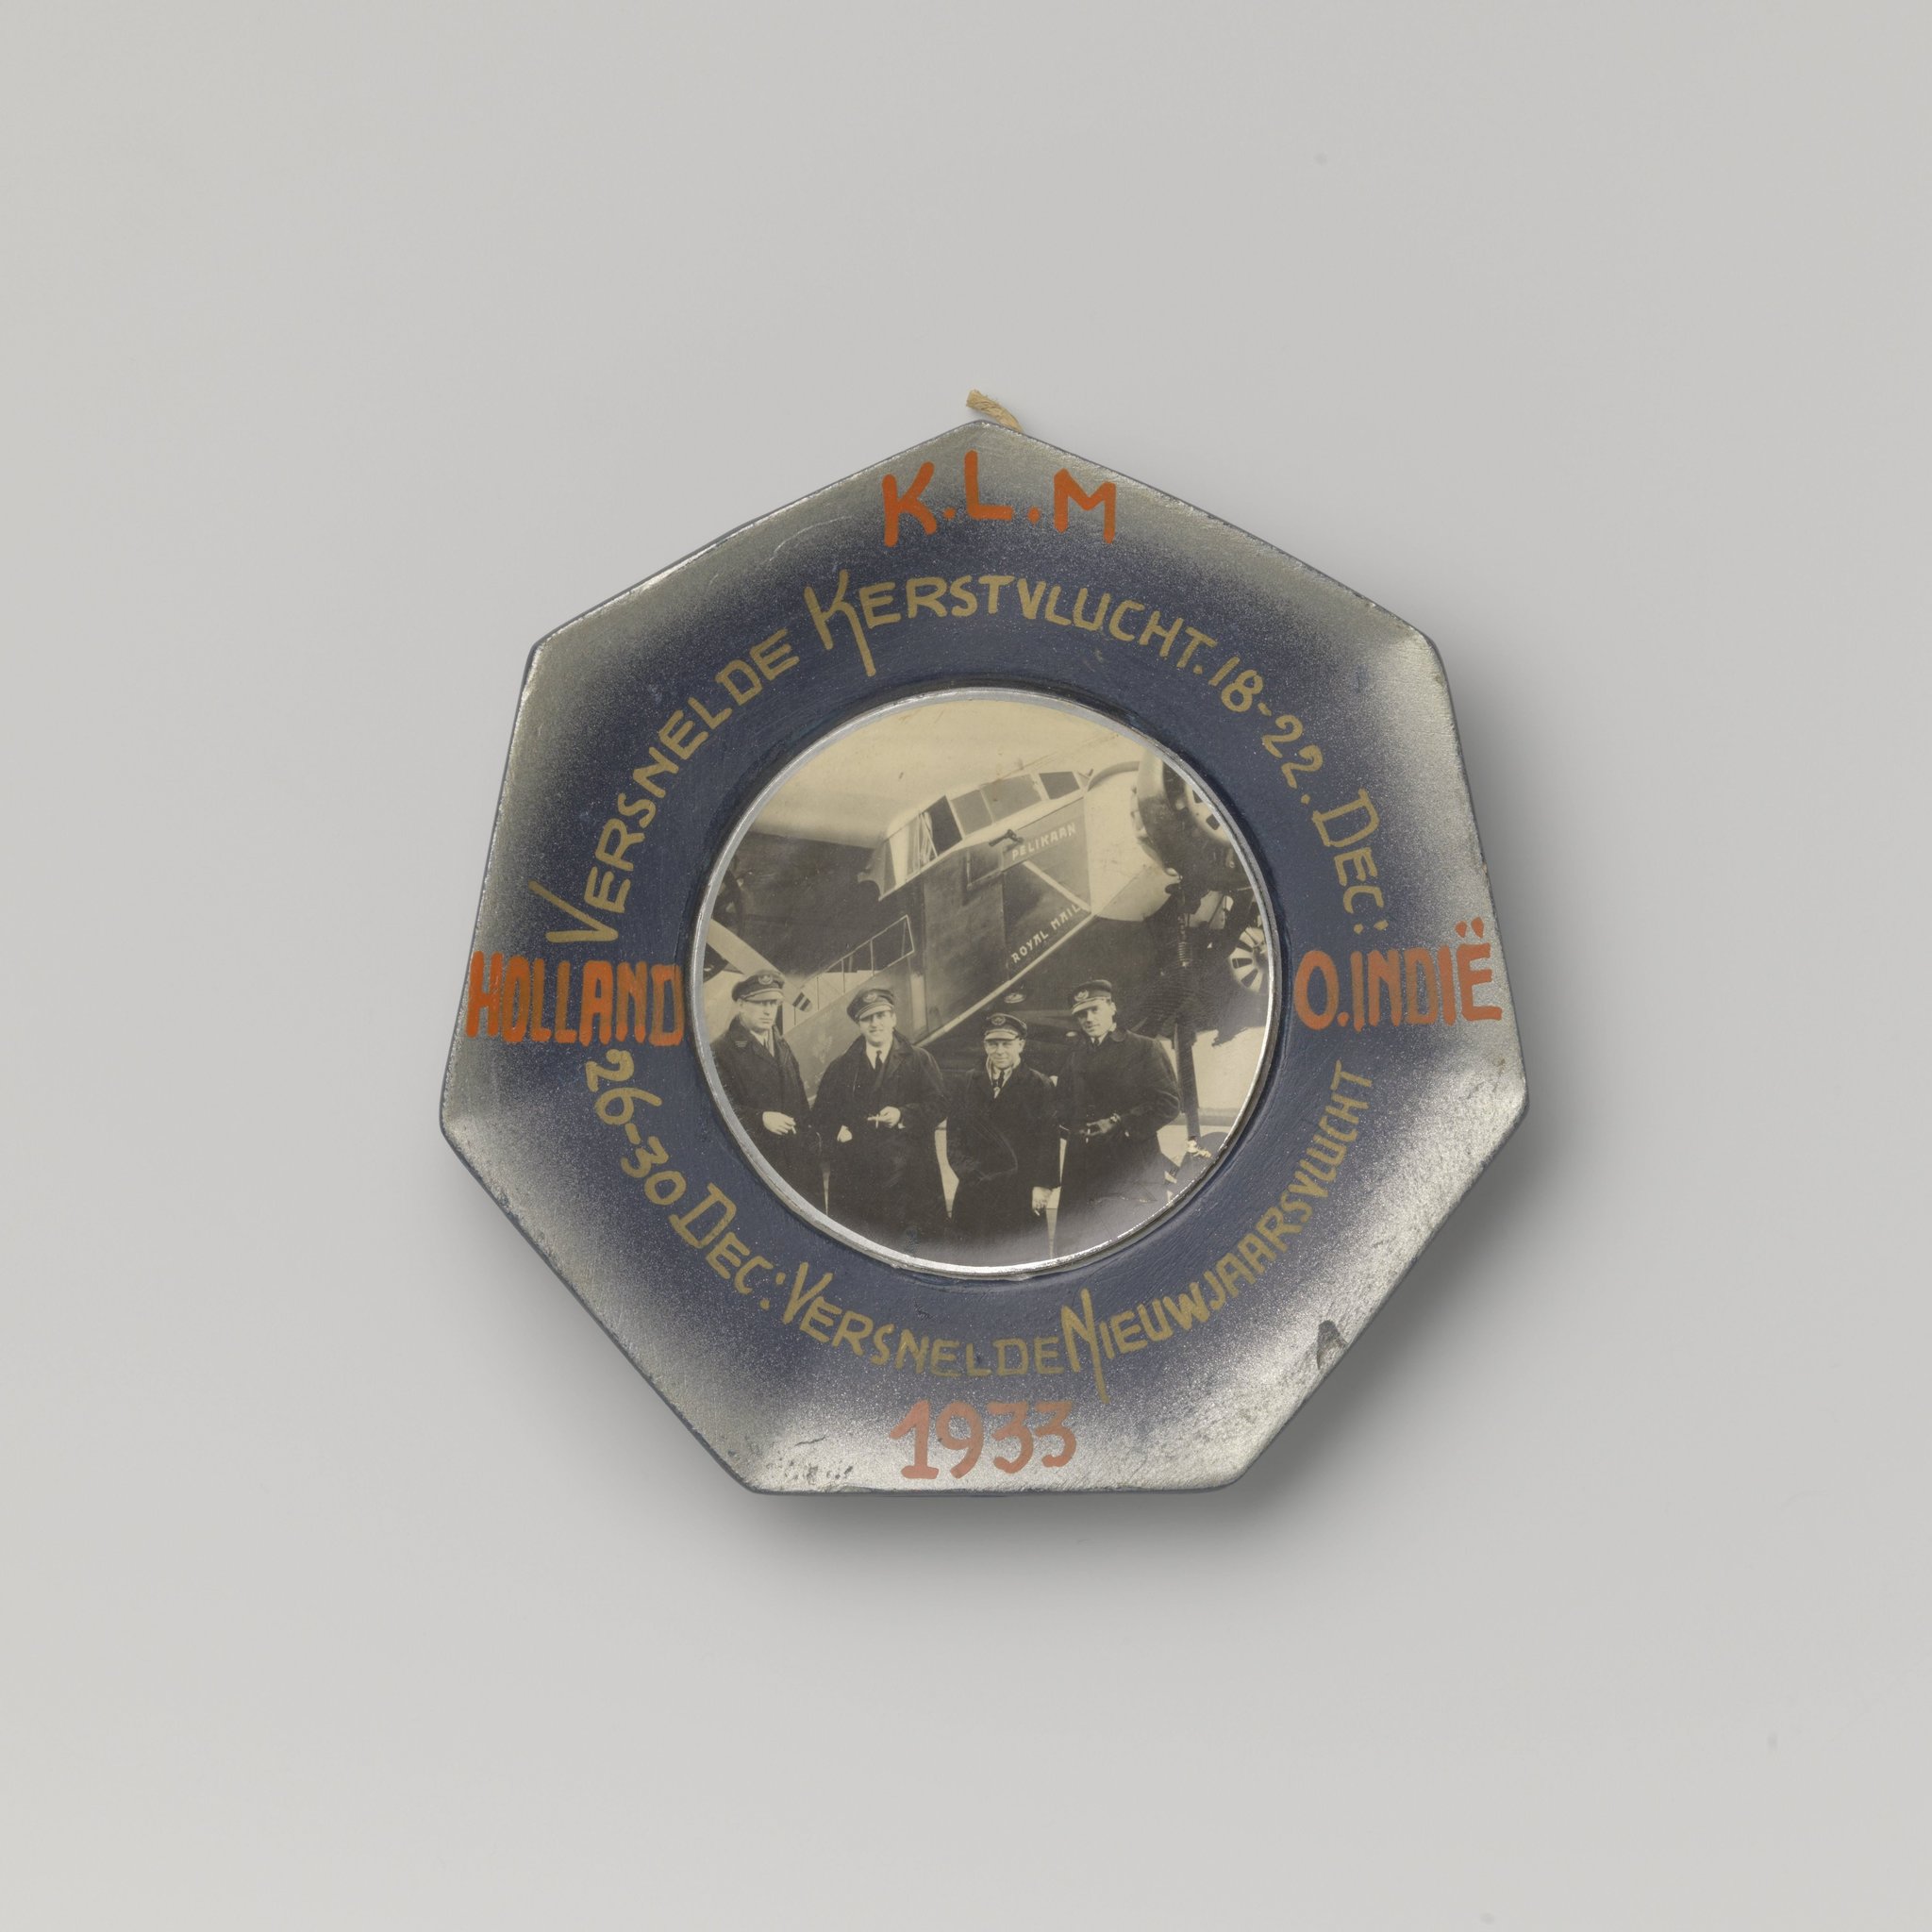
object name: photograph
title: Wandbord KLM met de bemanning van de Kerstvlucht 1933 Nederland - Nederlands-Indië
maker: Anonymous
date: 1933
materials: ceramic